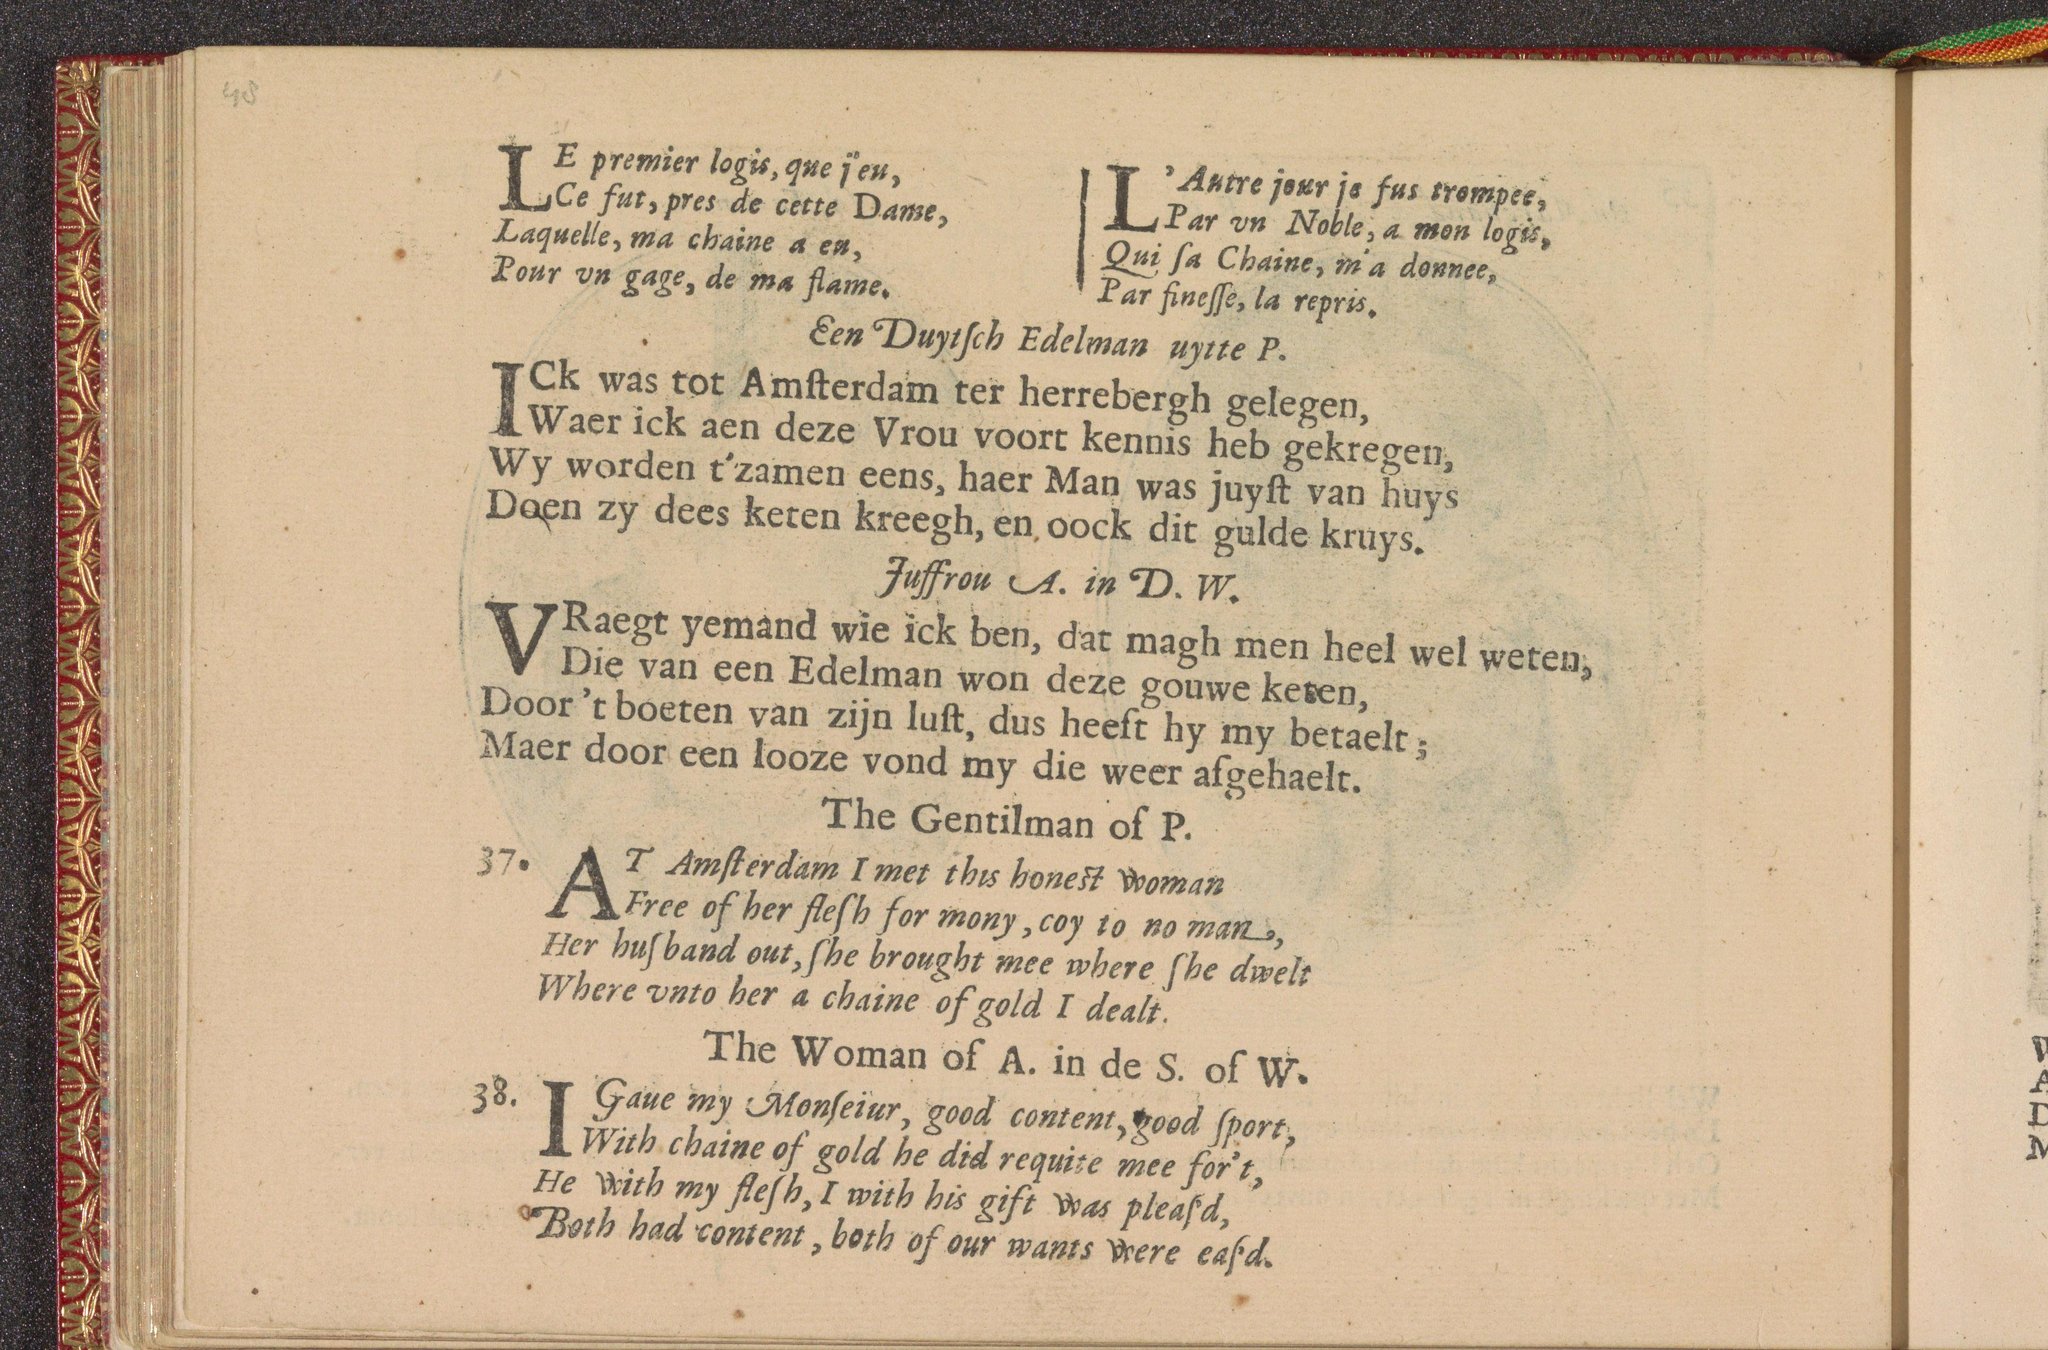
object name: album leaf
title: Kwatrijnen bij voorstellingen van een Duitse edelman en een vrouw uit Amsterdam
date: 1641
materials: paper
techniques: letterpress printing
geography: amsterdam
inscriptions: date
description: Drie keer twee kwatrijnen in het Frans, Nederlands en Engels bij voorstellingen van een Duitse edelman en een vrouw uit Amsterdam. Het blad maakt deel uit van een album.